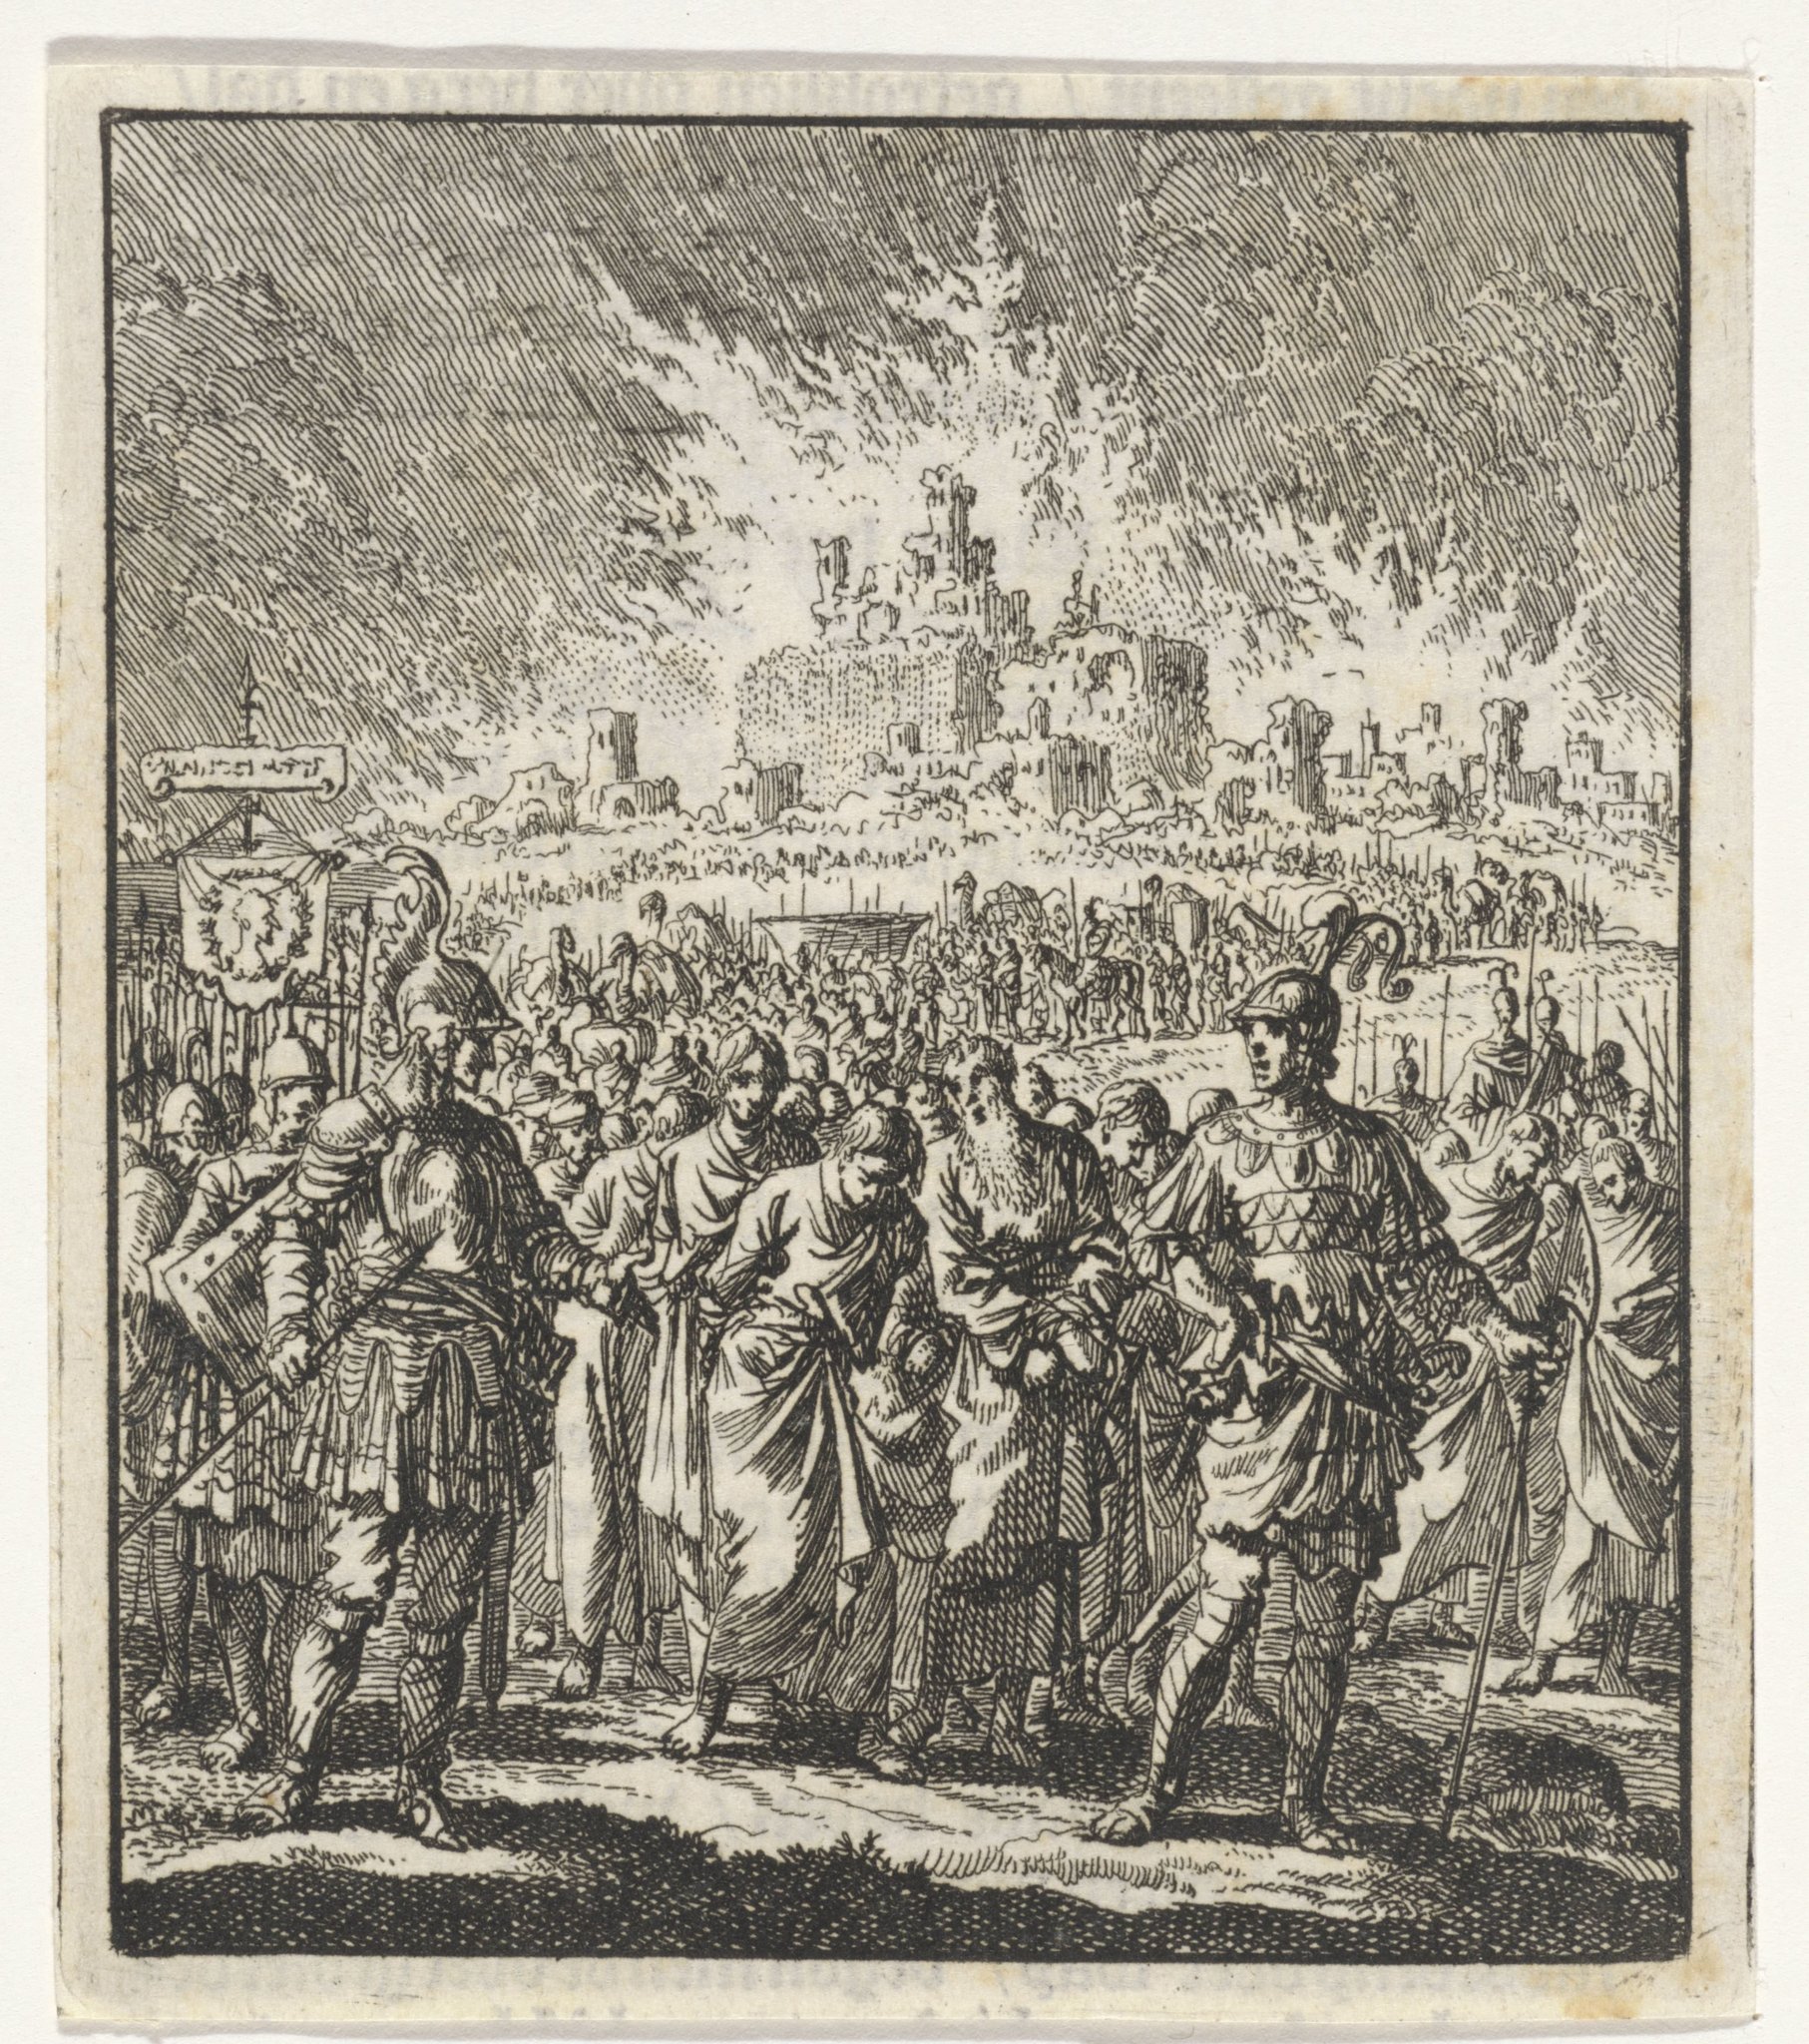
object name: book illustration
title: Israëlieten verlaten het brandende Jeruzalem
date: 1706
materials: paper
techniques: etching, letterpress printing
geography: amsterdam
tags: the fall of jerusalem ~ story of zedekiah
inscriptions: collector's mark: Lugt 2228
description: Illustratie voor: Schabaalje, Jean Philipsz. De vermeerderde lust-hof des gemoeds. Amsterdam: Jan Rieuwertsz. (II) en Barent Visscher, 1706, p. 260.